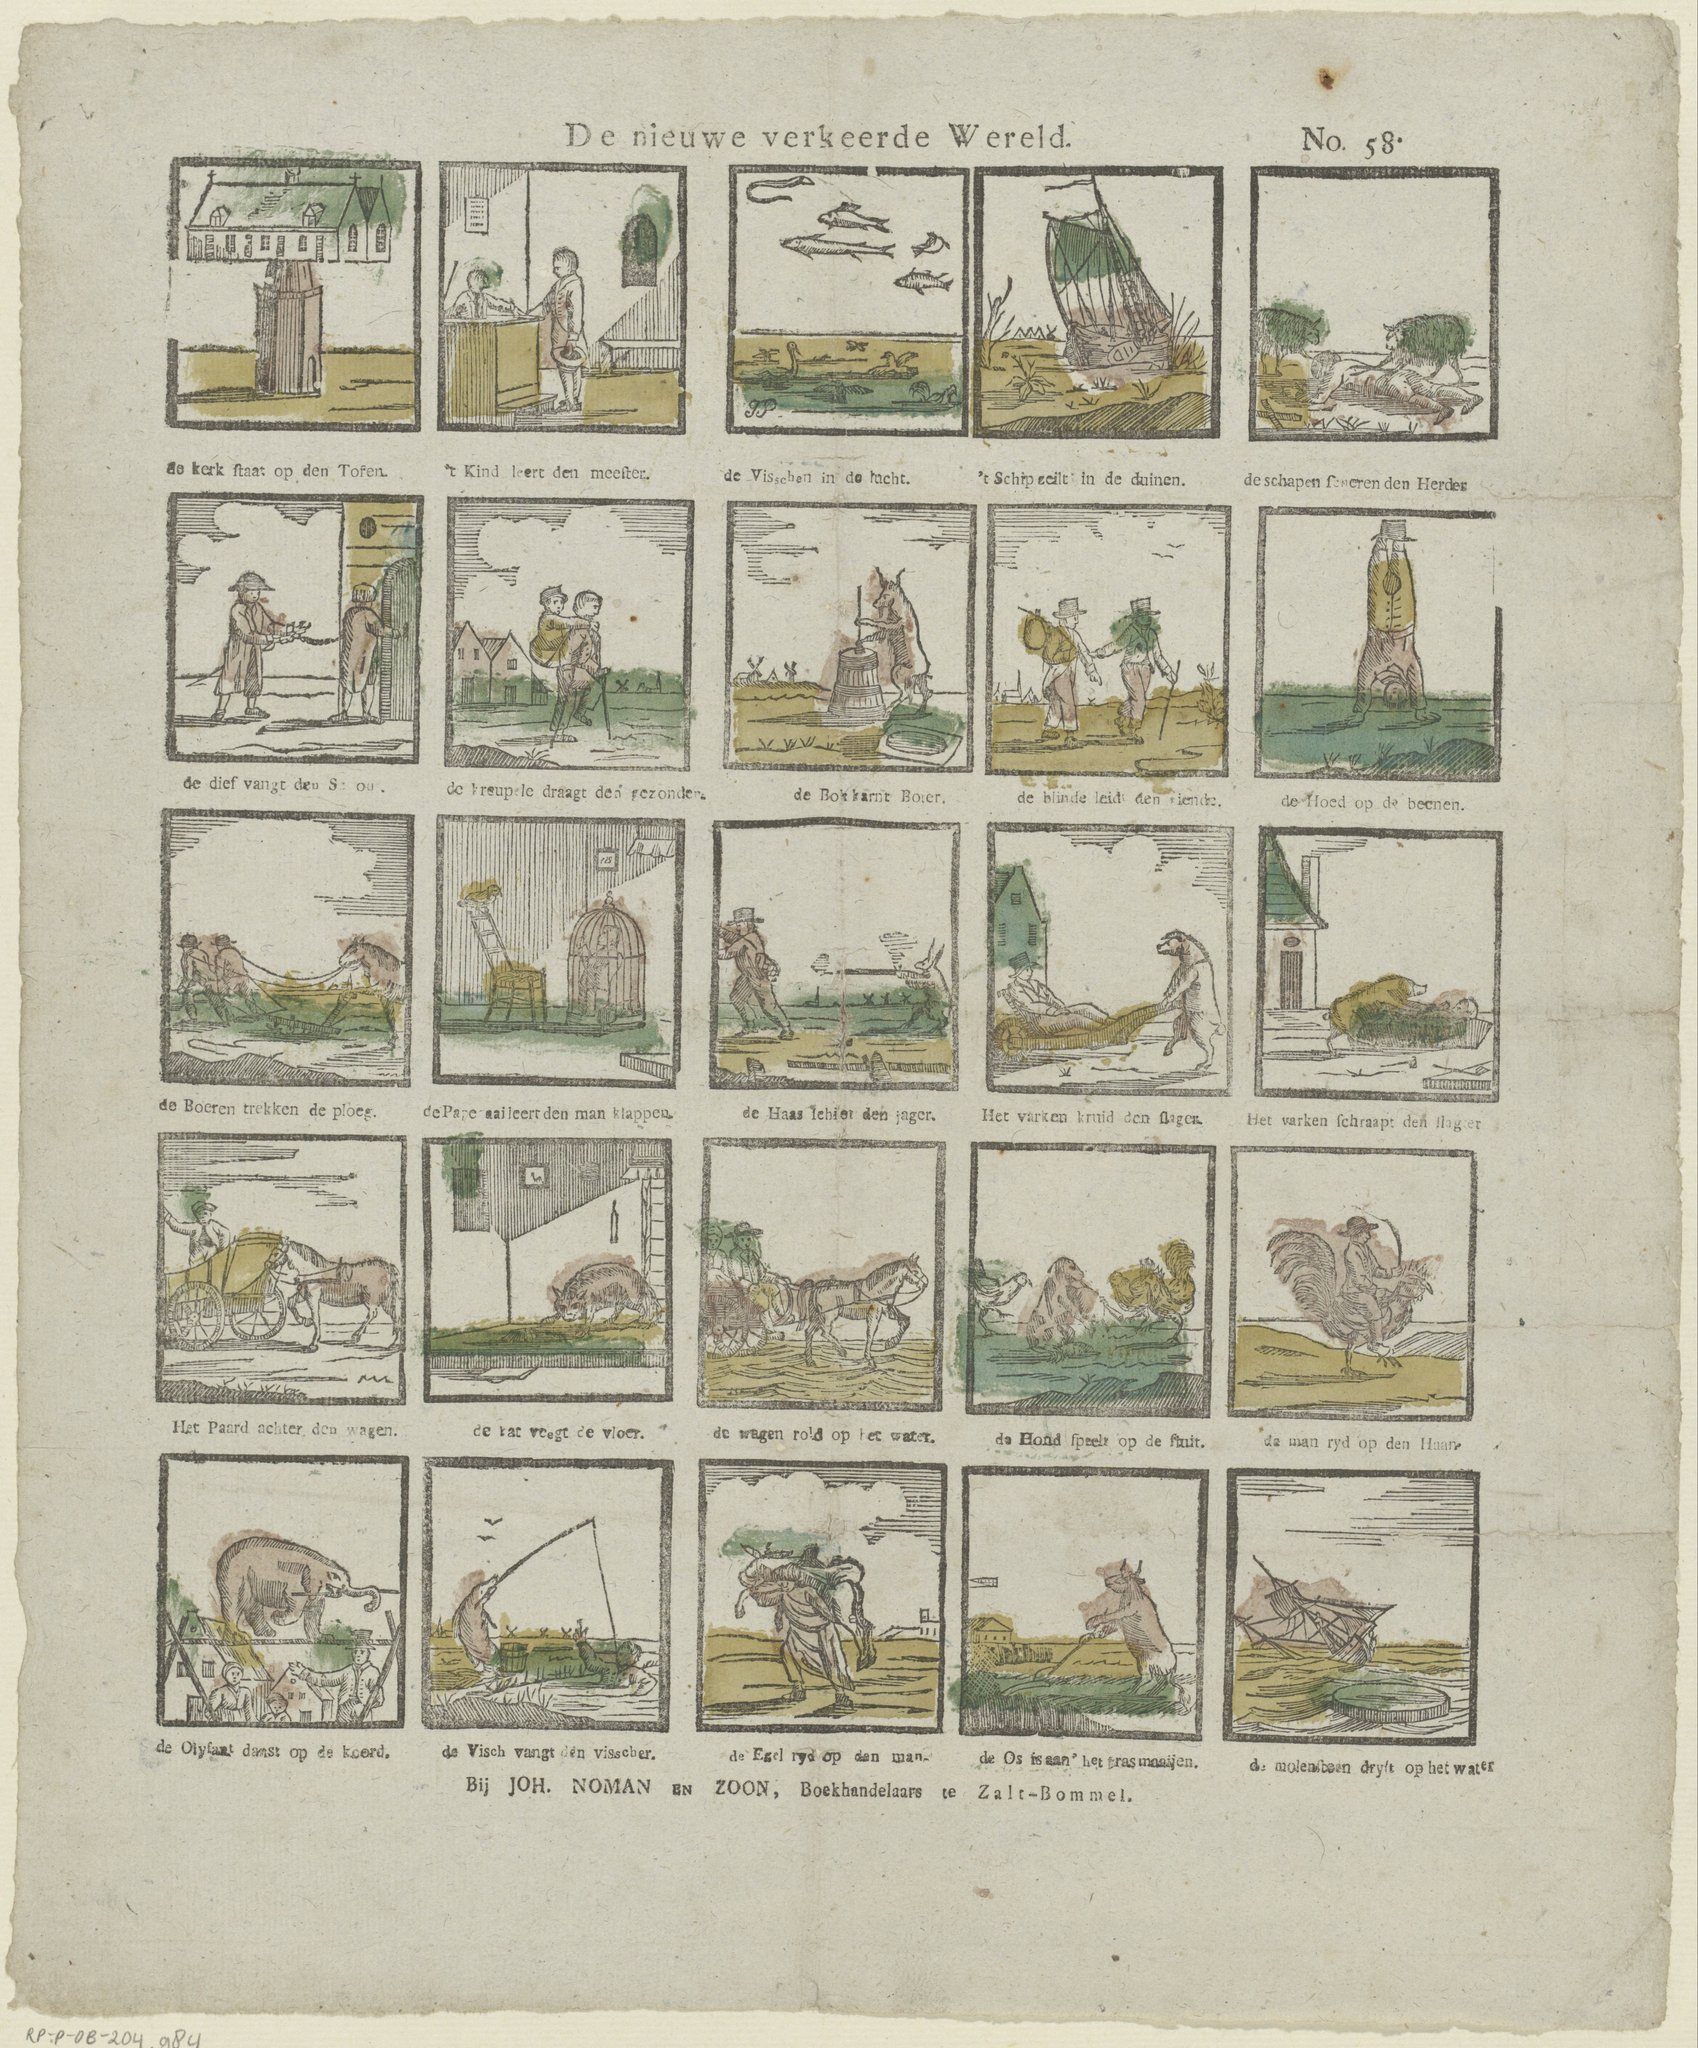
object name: print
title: De nieuwe verkeerde wereld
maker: jacob plügger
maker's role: print maker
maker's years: 1795-1871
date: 1830-1892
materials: paper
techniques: colour, letterpress printing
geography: zaltbommel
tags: 'mundus inversus', the reversed world, the topsy-turvy world, 'le monde bestourné', animals acting as human beings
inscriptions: collector's mark: Lugt 2760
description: Blad met 25 voorstellingen van de verkeerde wereld, waar onder andere dieren zich als mensen gedragen. Onder elke afbeelding een onderschrift. Genummerd rechtsboven: No. 58.